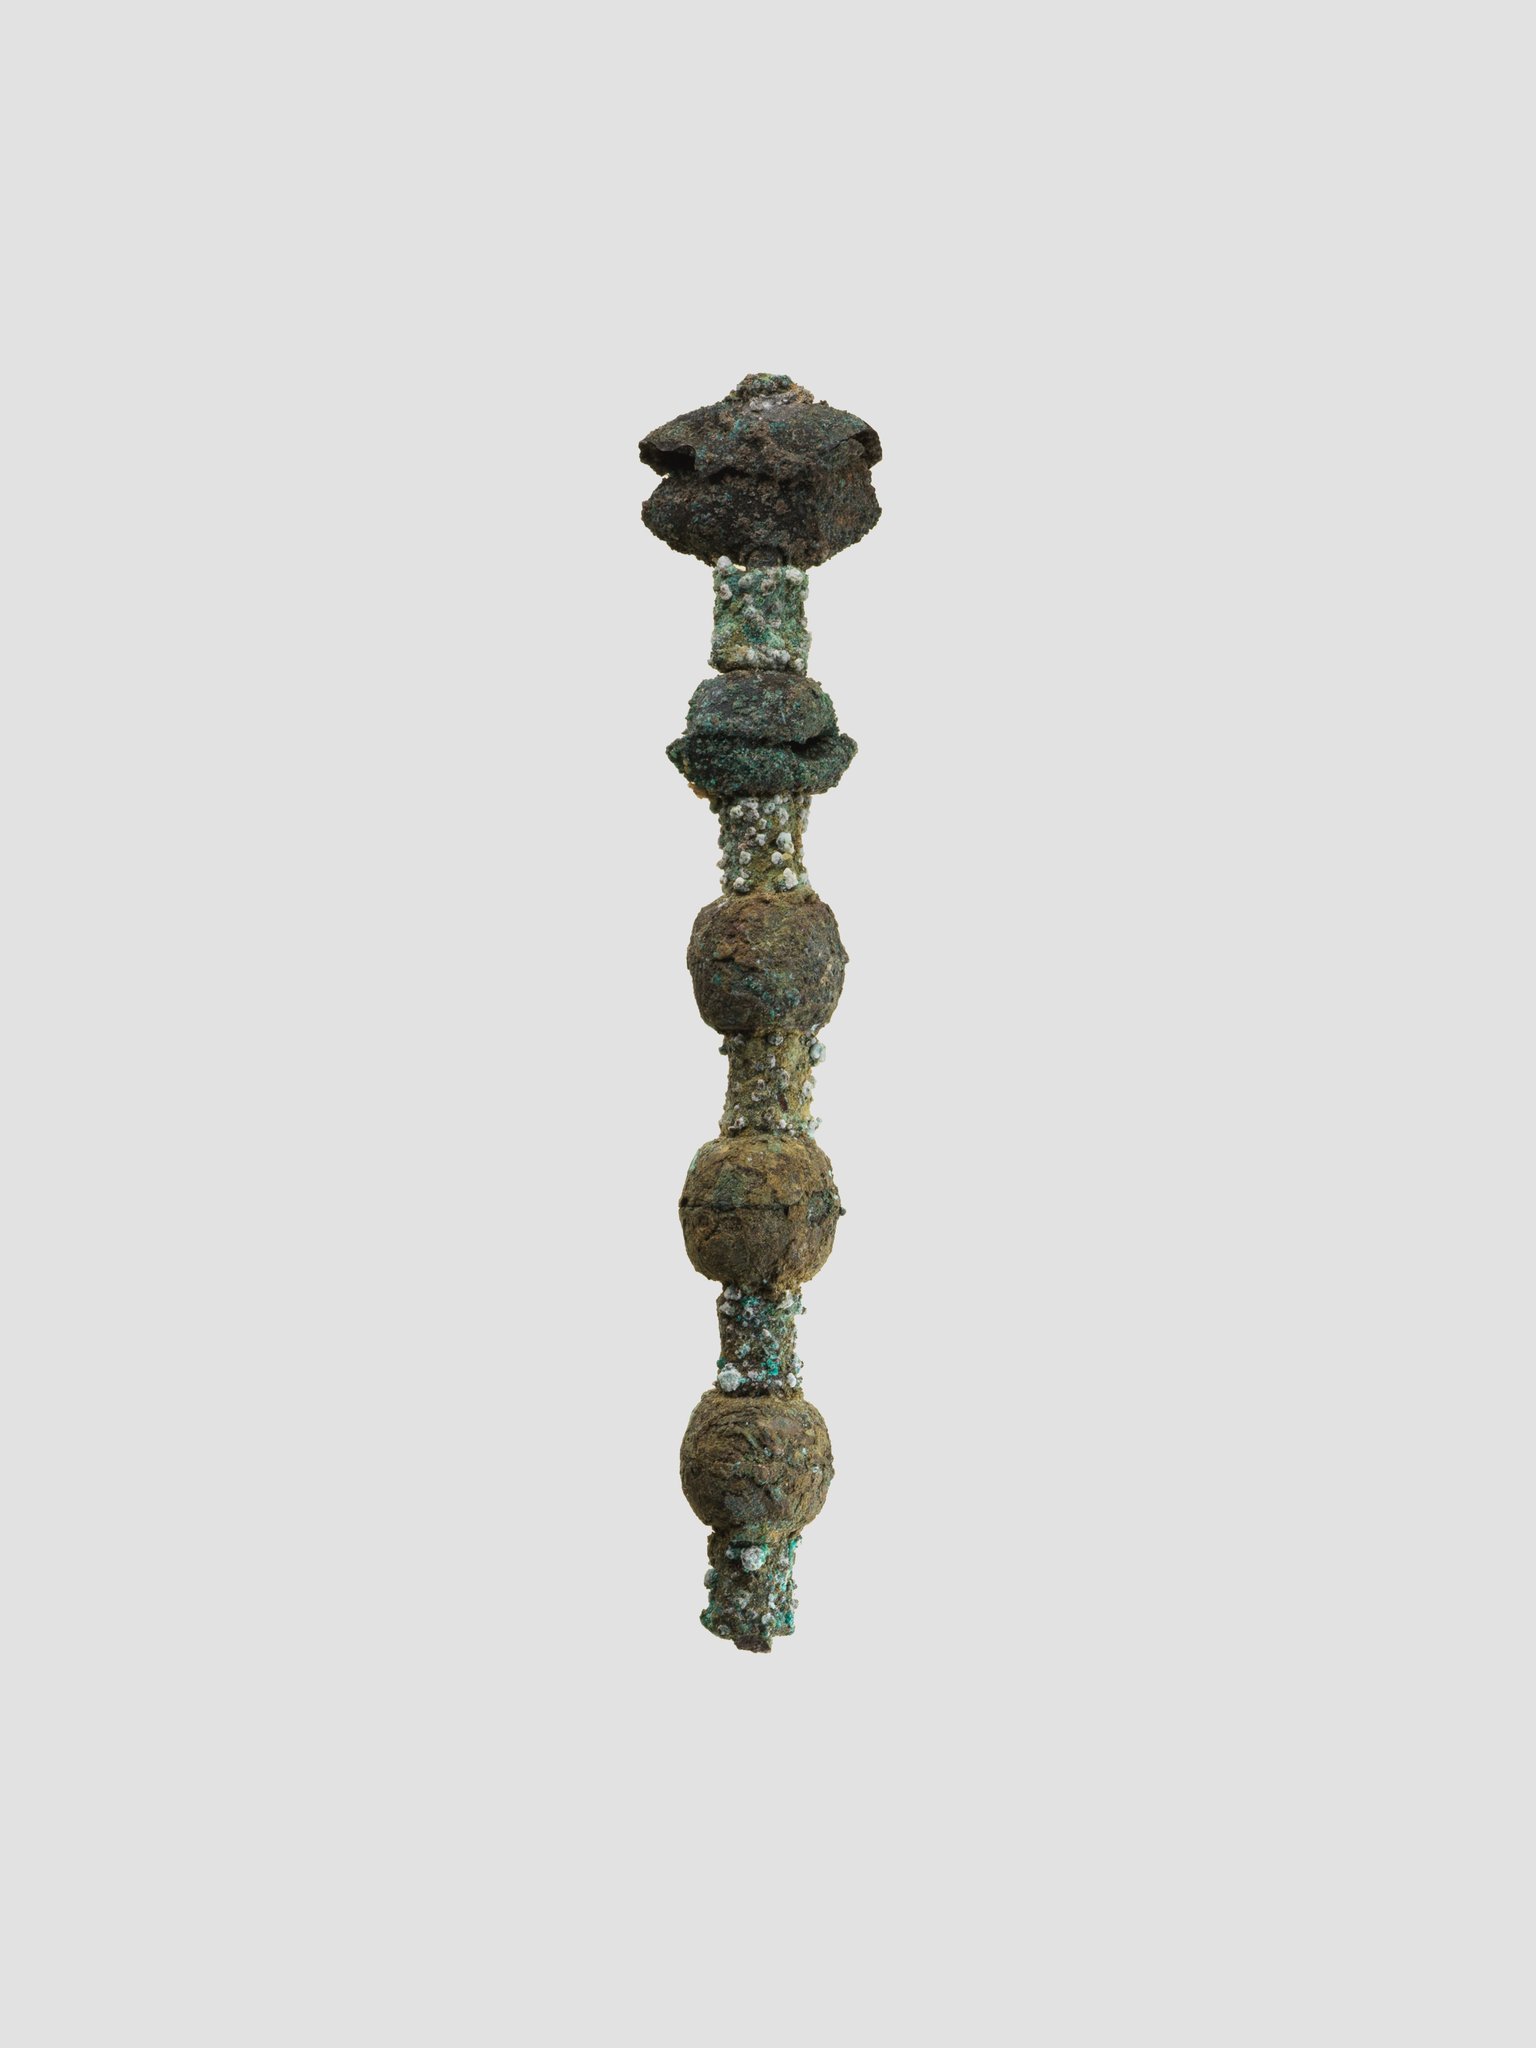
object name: earring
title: Bronze earring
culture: alanic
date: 601-900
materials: metal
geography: caucasus